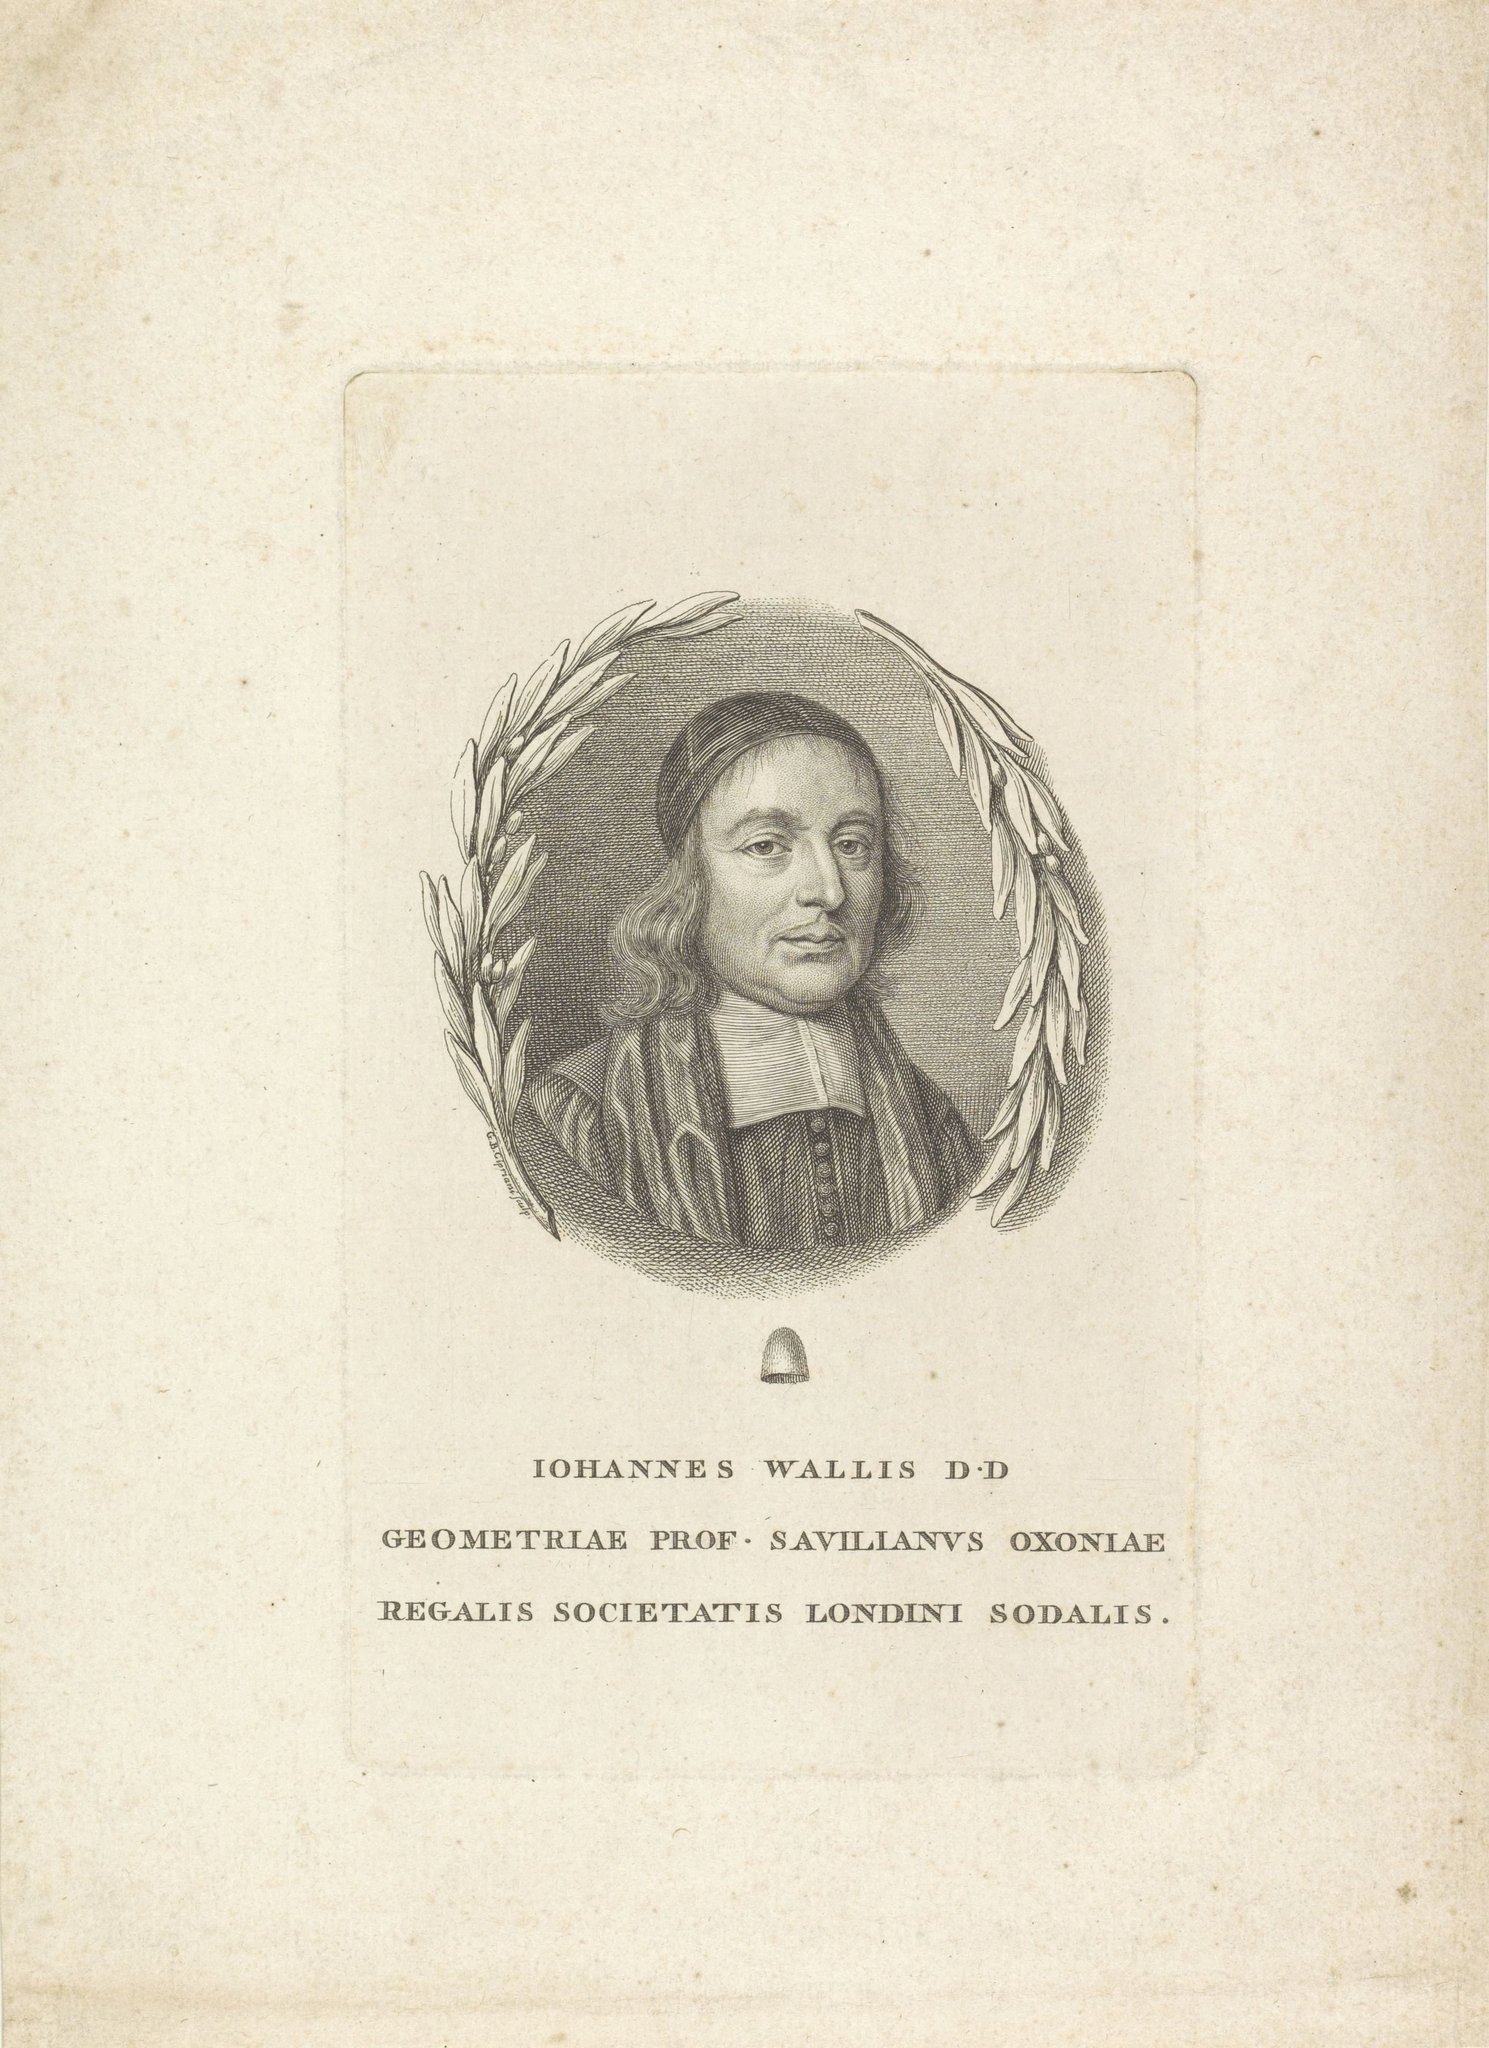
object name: print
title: Portret van wiskundige John Wallis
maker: giovanni battista cipriani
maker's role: draughtsman, print maker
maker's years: 1727-1785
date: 1737-1785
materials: paper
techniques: engraving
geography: italy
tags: historical persons, science and technology (+ portrait of scholar, scientist)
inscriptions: collector's mark: Lugt 2228